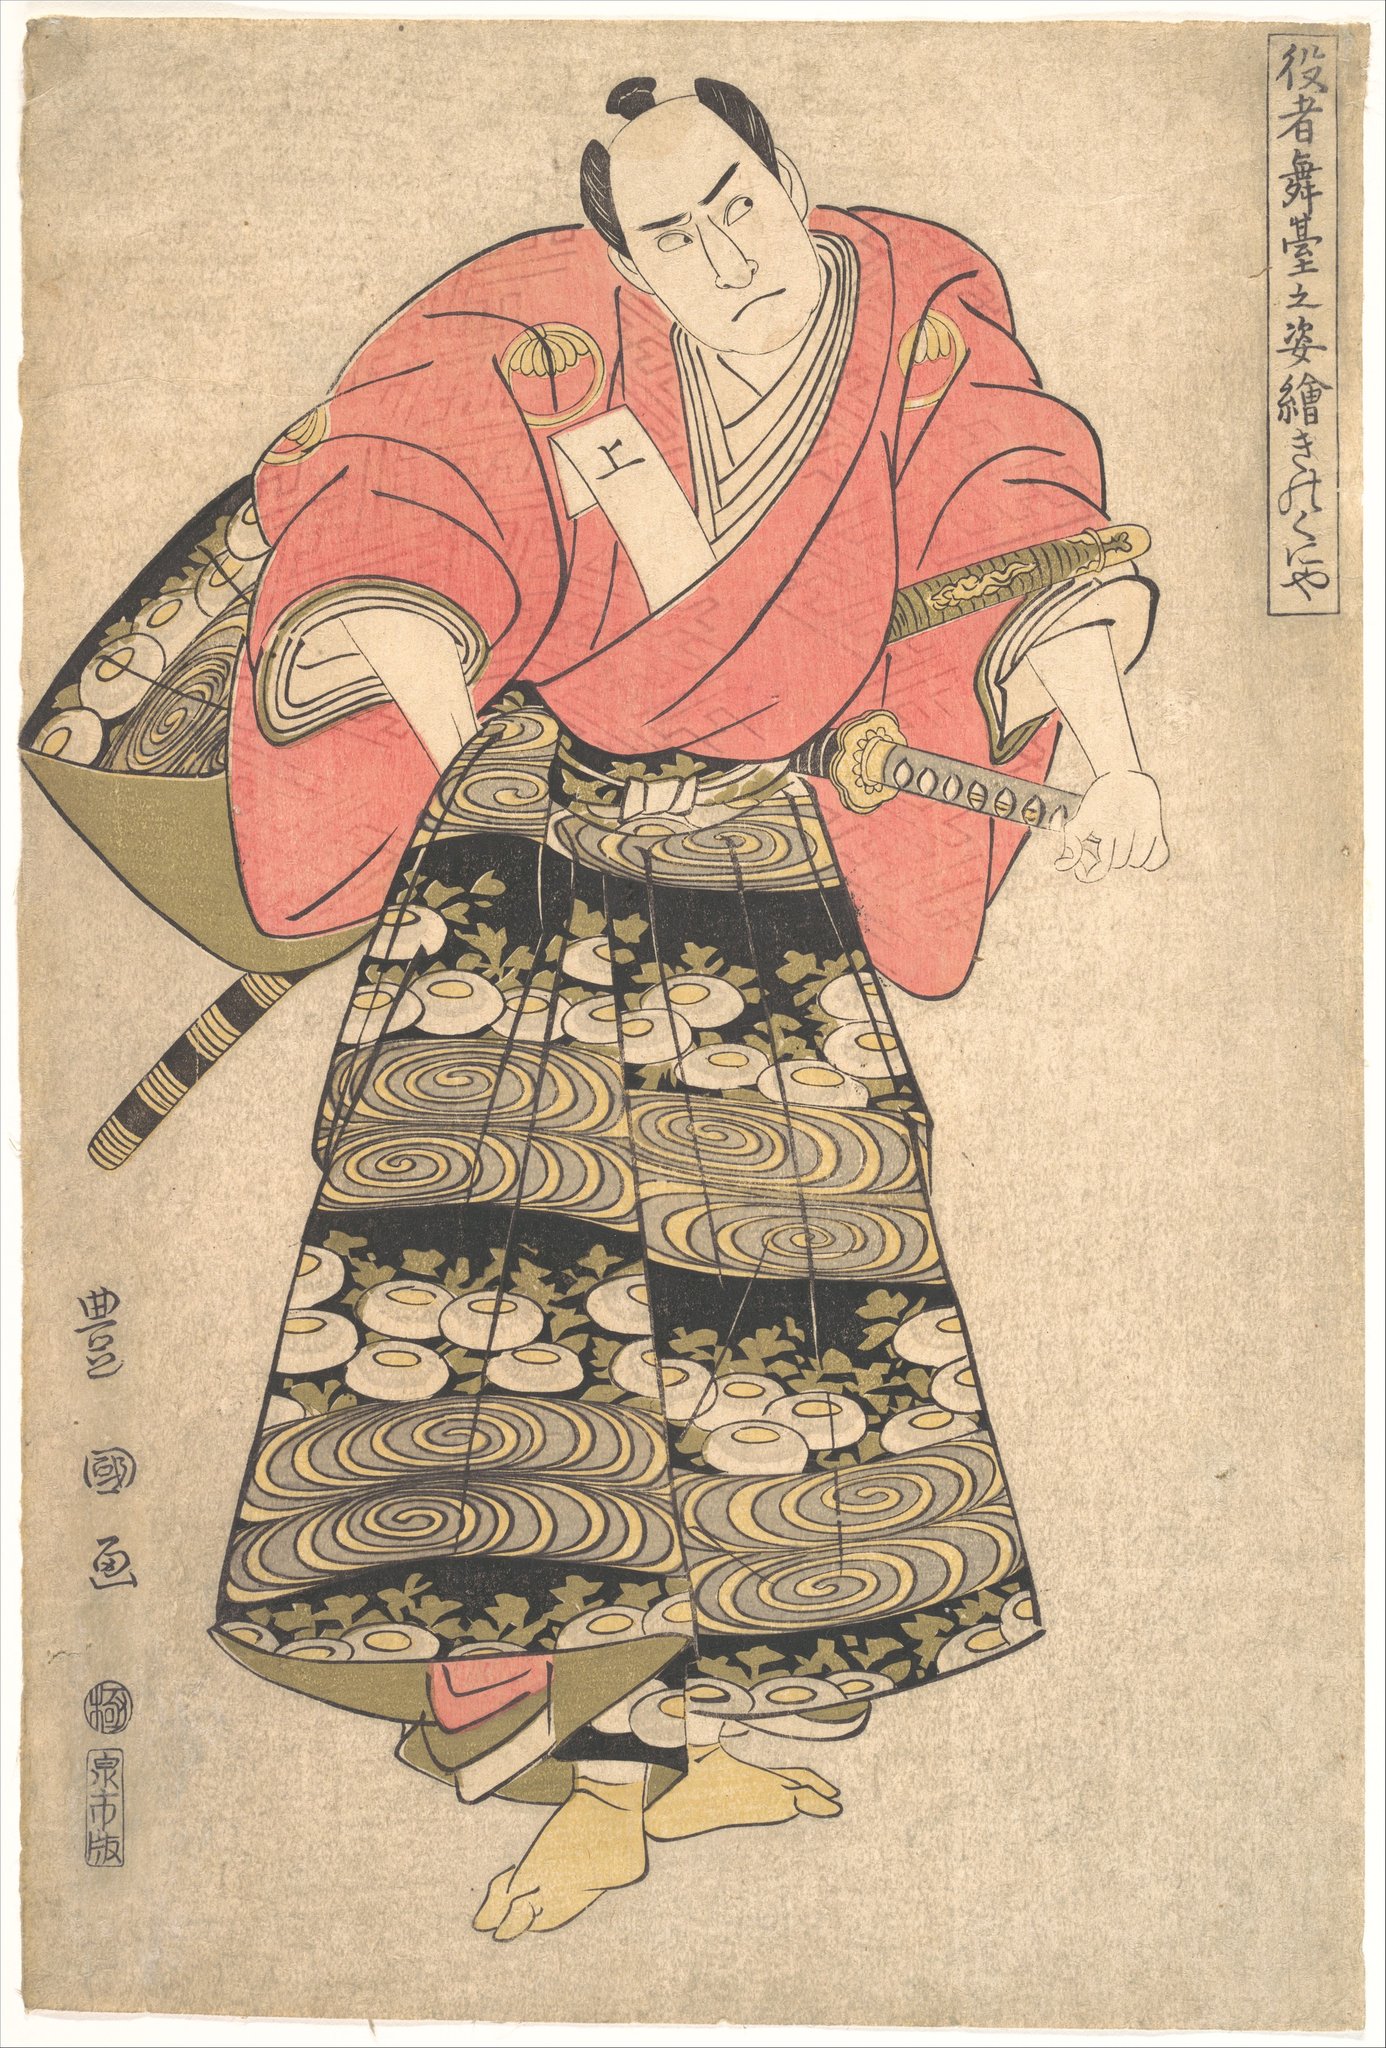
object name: print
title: The Actor Sawamura Sōjūrō III in the Role of Shimada Jūzaburō, from the series "Image of Actors on Stage"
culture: japanese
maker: utagawa toyokuni i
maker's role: artist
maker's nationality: japanese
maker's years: 1769-1825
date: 1795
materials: ink, paper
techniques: woodblock print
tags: swords,men,actors